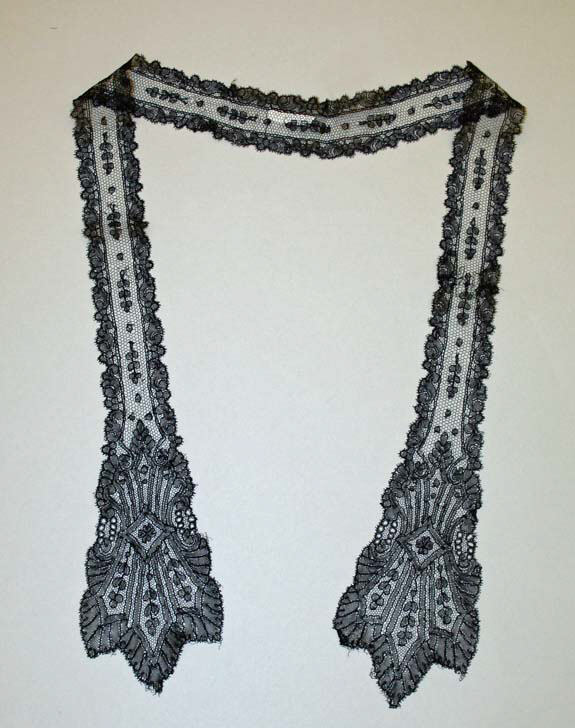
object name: barbe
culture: american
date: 1834-1866